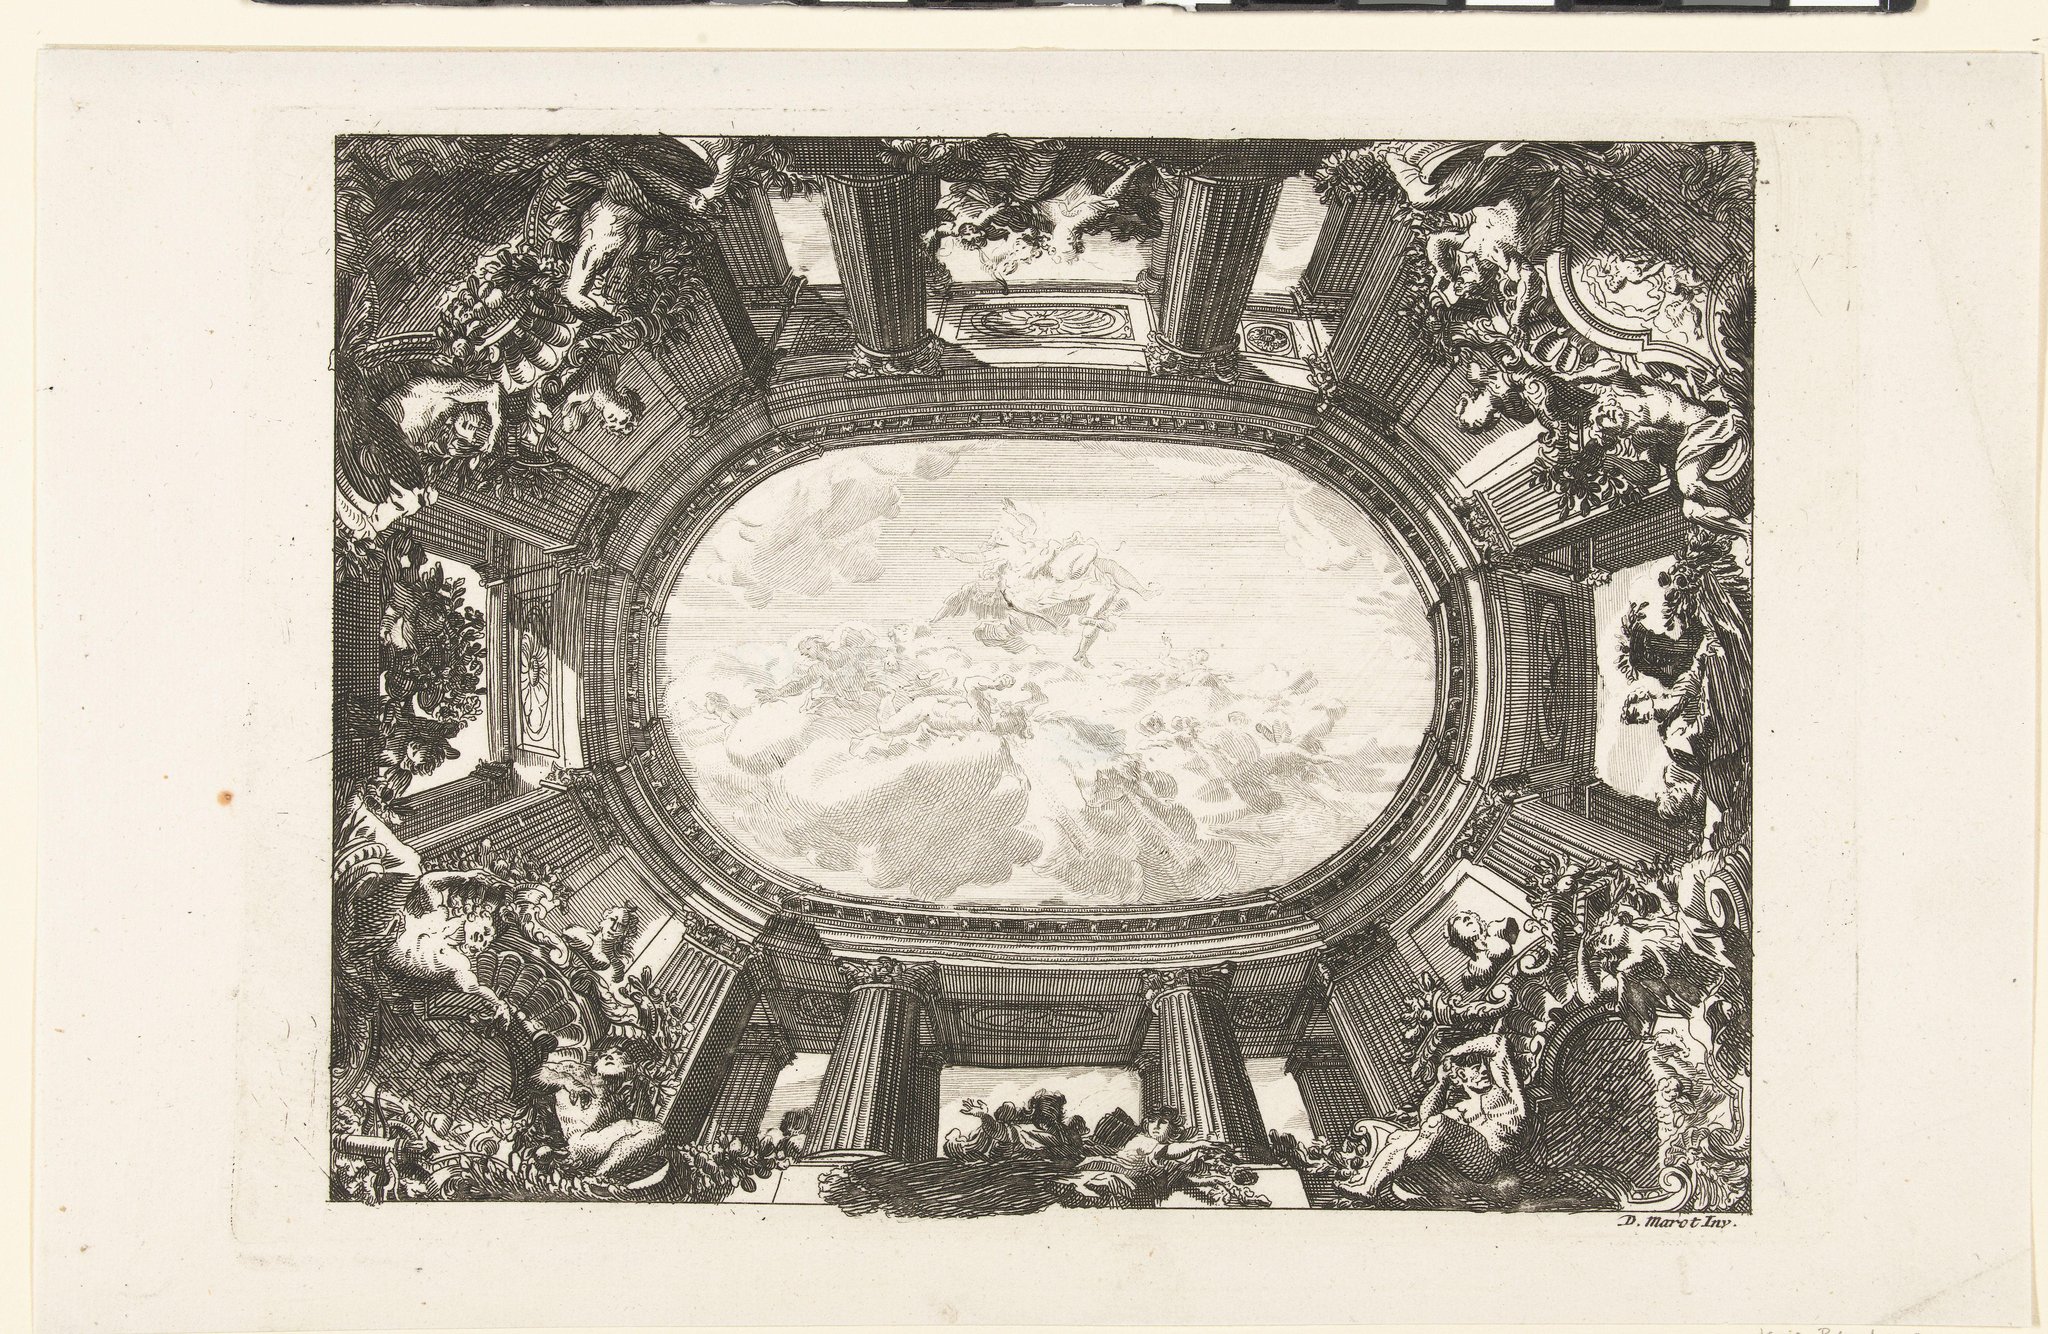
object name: ornament print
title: Trompe-l'oeil plafond met mythologische voorstelling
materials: paper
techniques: etching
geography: netherlands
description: Het plafond wordt gesteund door zuilen, pilasters en een kroonlijst van de Korintische orde. In de hoeken zijn medaillons aanwezig, van onderaf gezien. Tegenzijdige kopie naar prent uit serie met plafonds ontworpen en uitgegeven door Daniel Marot.